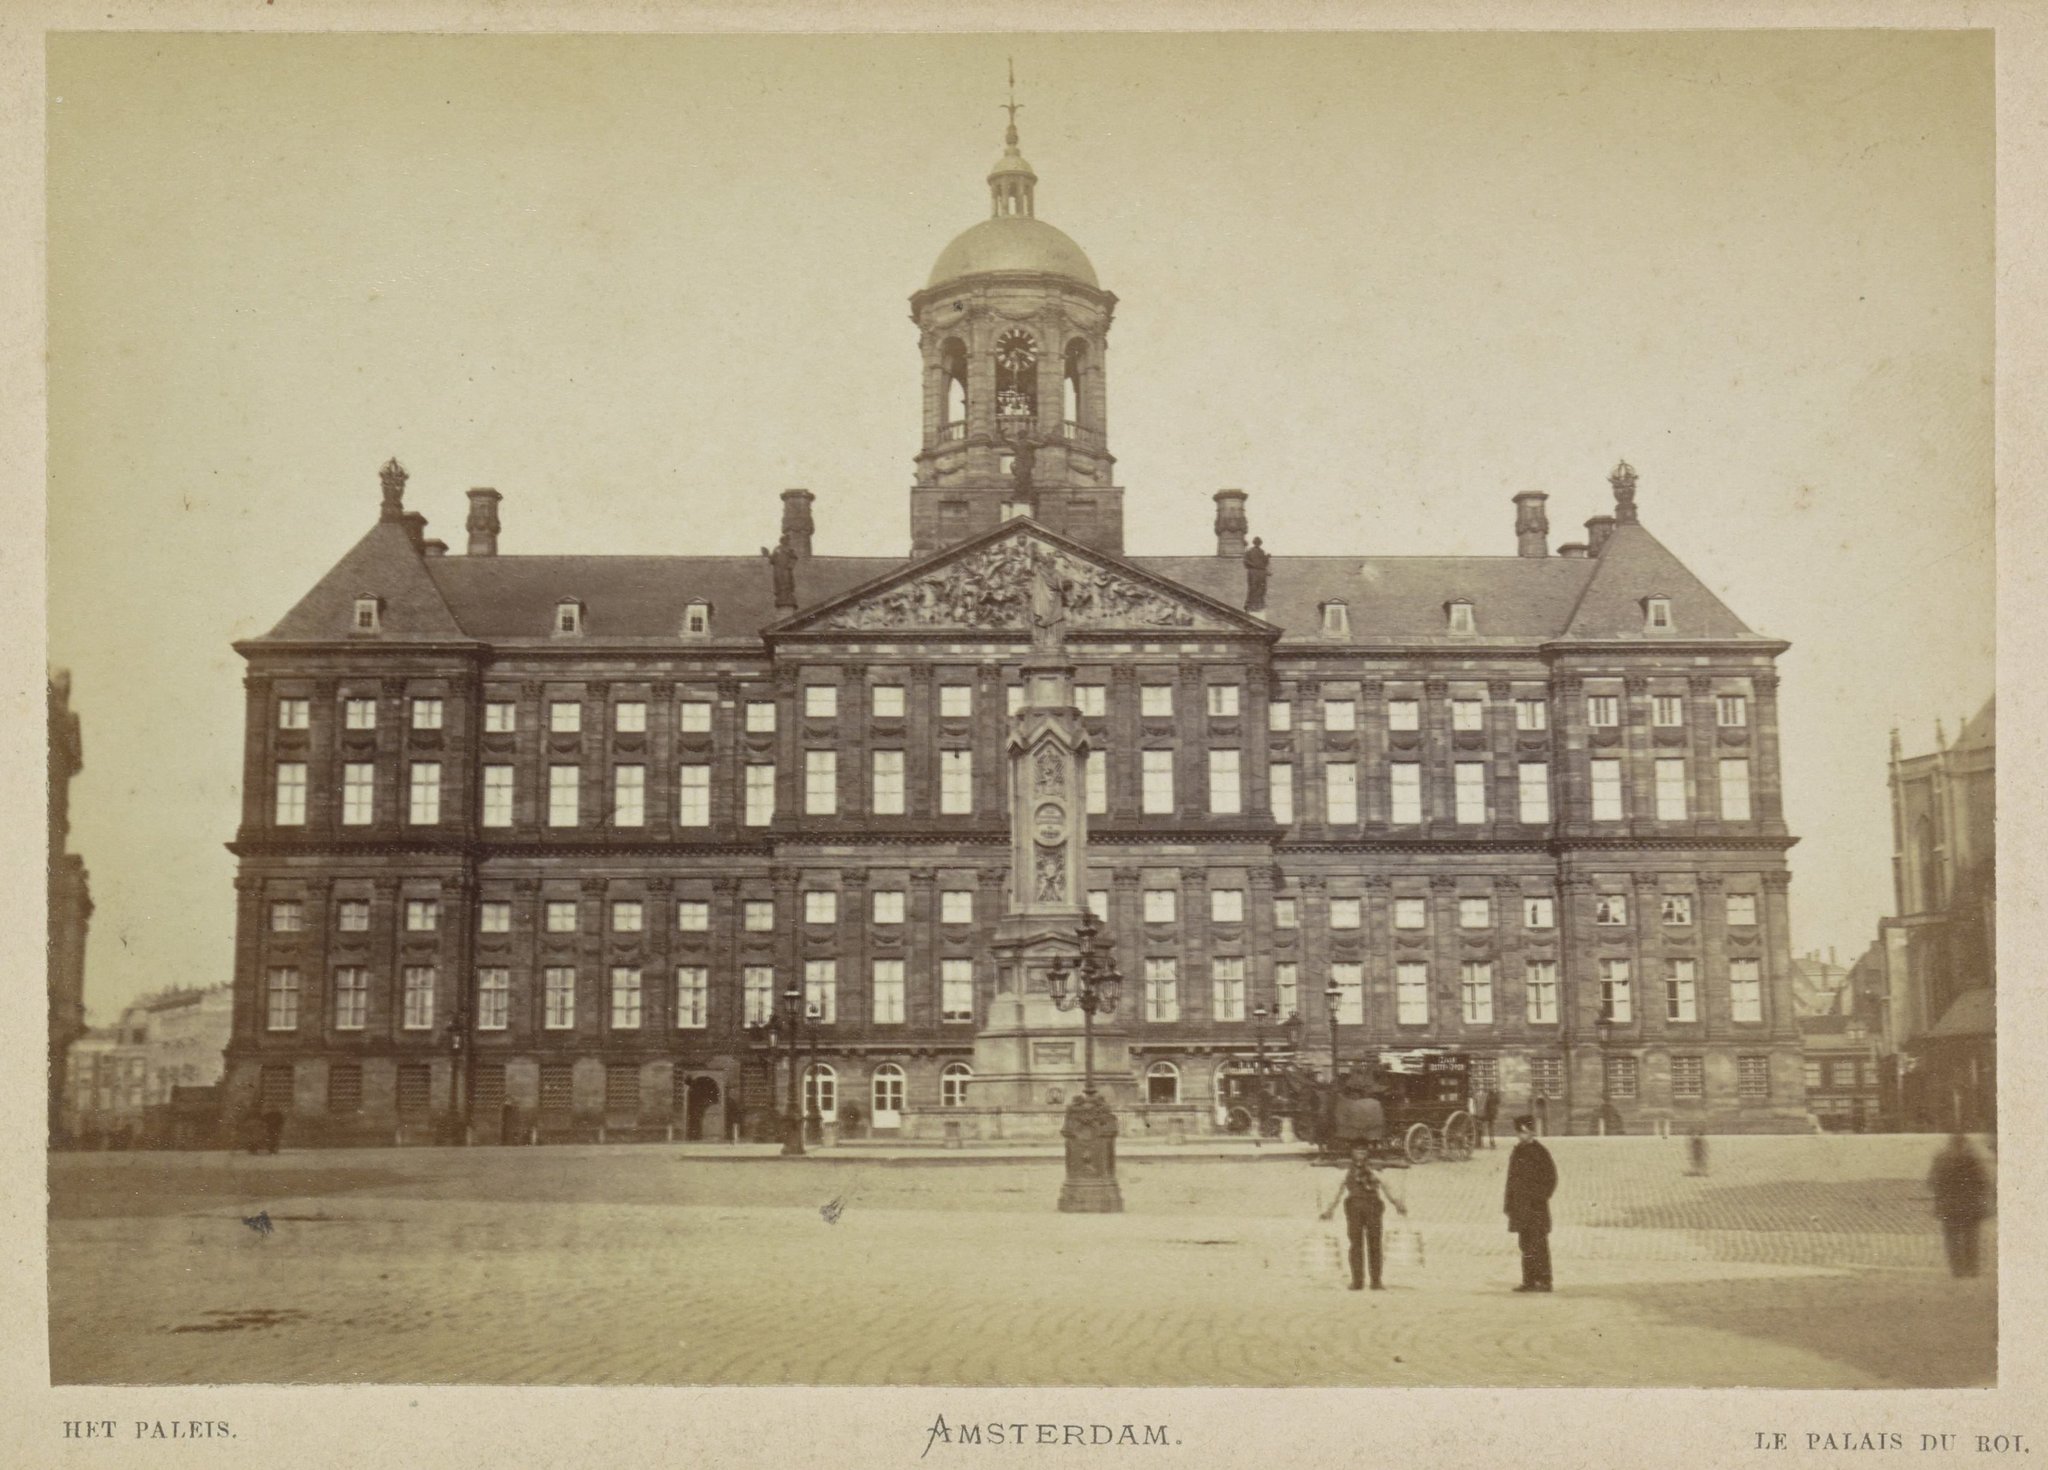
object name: cabinet photograph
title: Gezicht op het Koninklijk Paleis op de Dam met ervoor 'Naatje'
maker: andries jager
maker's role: publisher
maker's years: 1825-1905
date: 1860-1880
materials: cardboard, photographic support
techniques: albumen print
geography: amsterdam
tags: palace, monument, statue, square, place, circus, etc. (+ city(-scape) with figures, staffage), prospect of city, town panorama, silhouette of city, royal palace of amsterdam, amsterdam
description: Onderdeel van Leporelloalbum met twaalf foto's van Amsterdam.